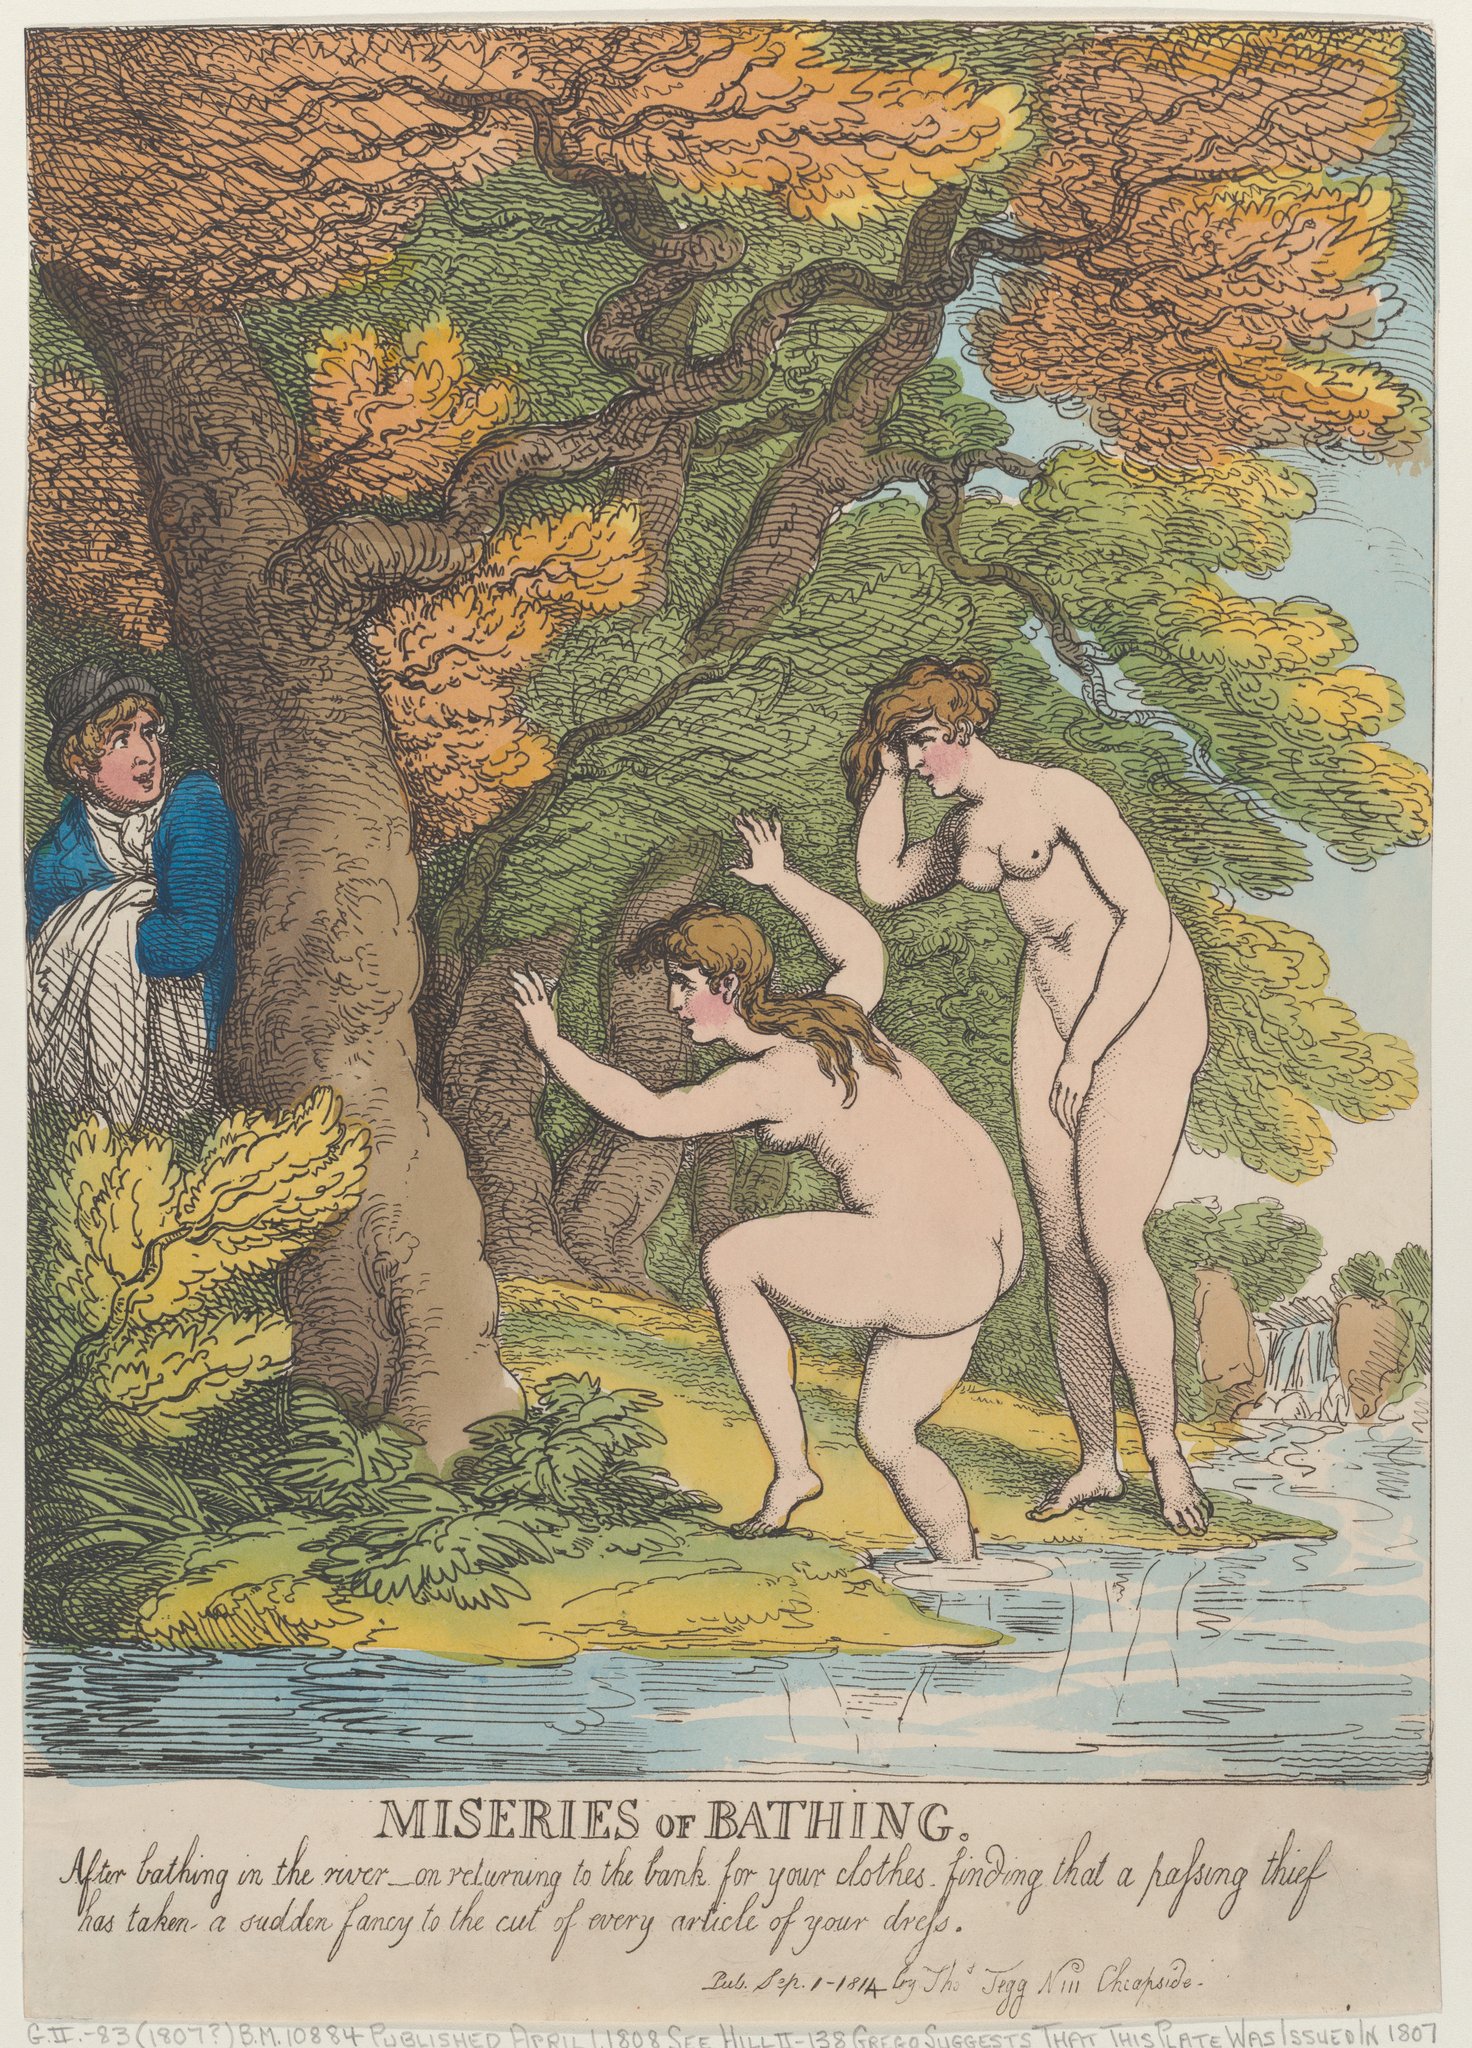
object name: print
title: Miseries of Bathing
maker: thomas rowlandson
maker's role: artist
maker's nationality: british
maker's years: 1757-1827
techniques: etching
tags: satire,men,women,female nudes,bathing